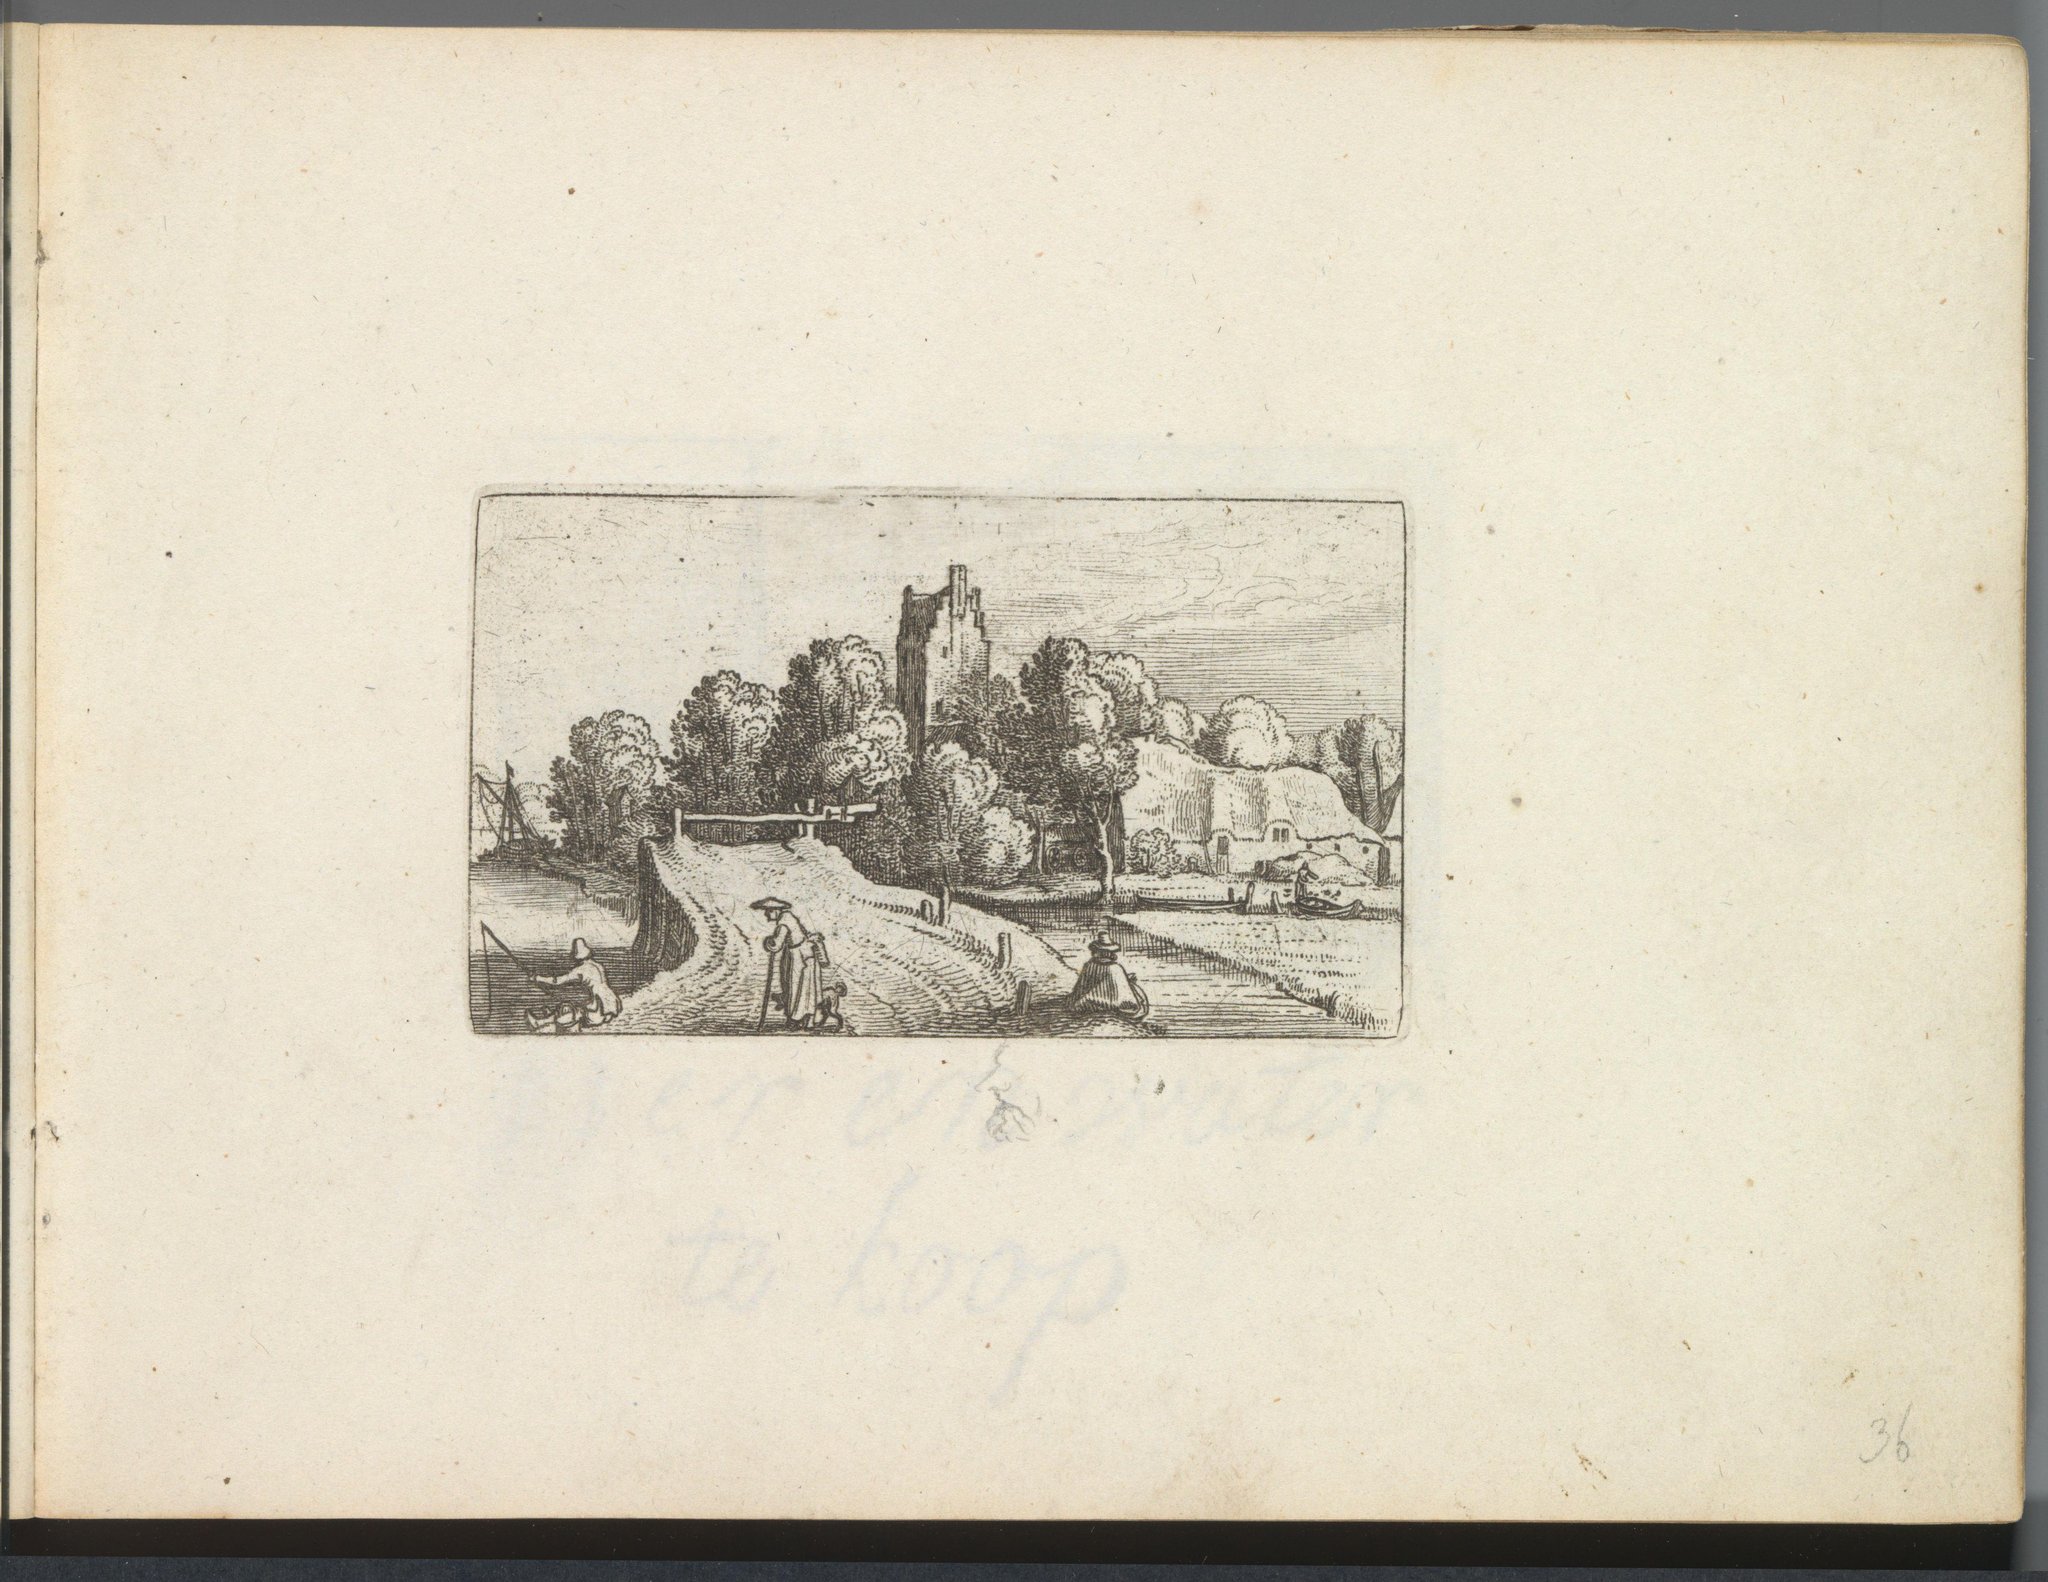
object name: album leaf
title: Huis Kostverloren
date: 1601-1652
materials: paper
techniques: etching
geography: amsterdam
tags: landscapes, angling, fisherman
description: Gezicht op Huis Kostverloren nabij Amsterdam, waarnaast een lage boerderij. Op de voorgrond een visser en een vrouw, leunend op haar stok, met een hond. Rechts zit een figuur aan de waterkant. De prent maakt deel uit van een album.